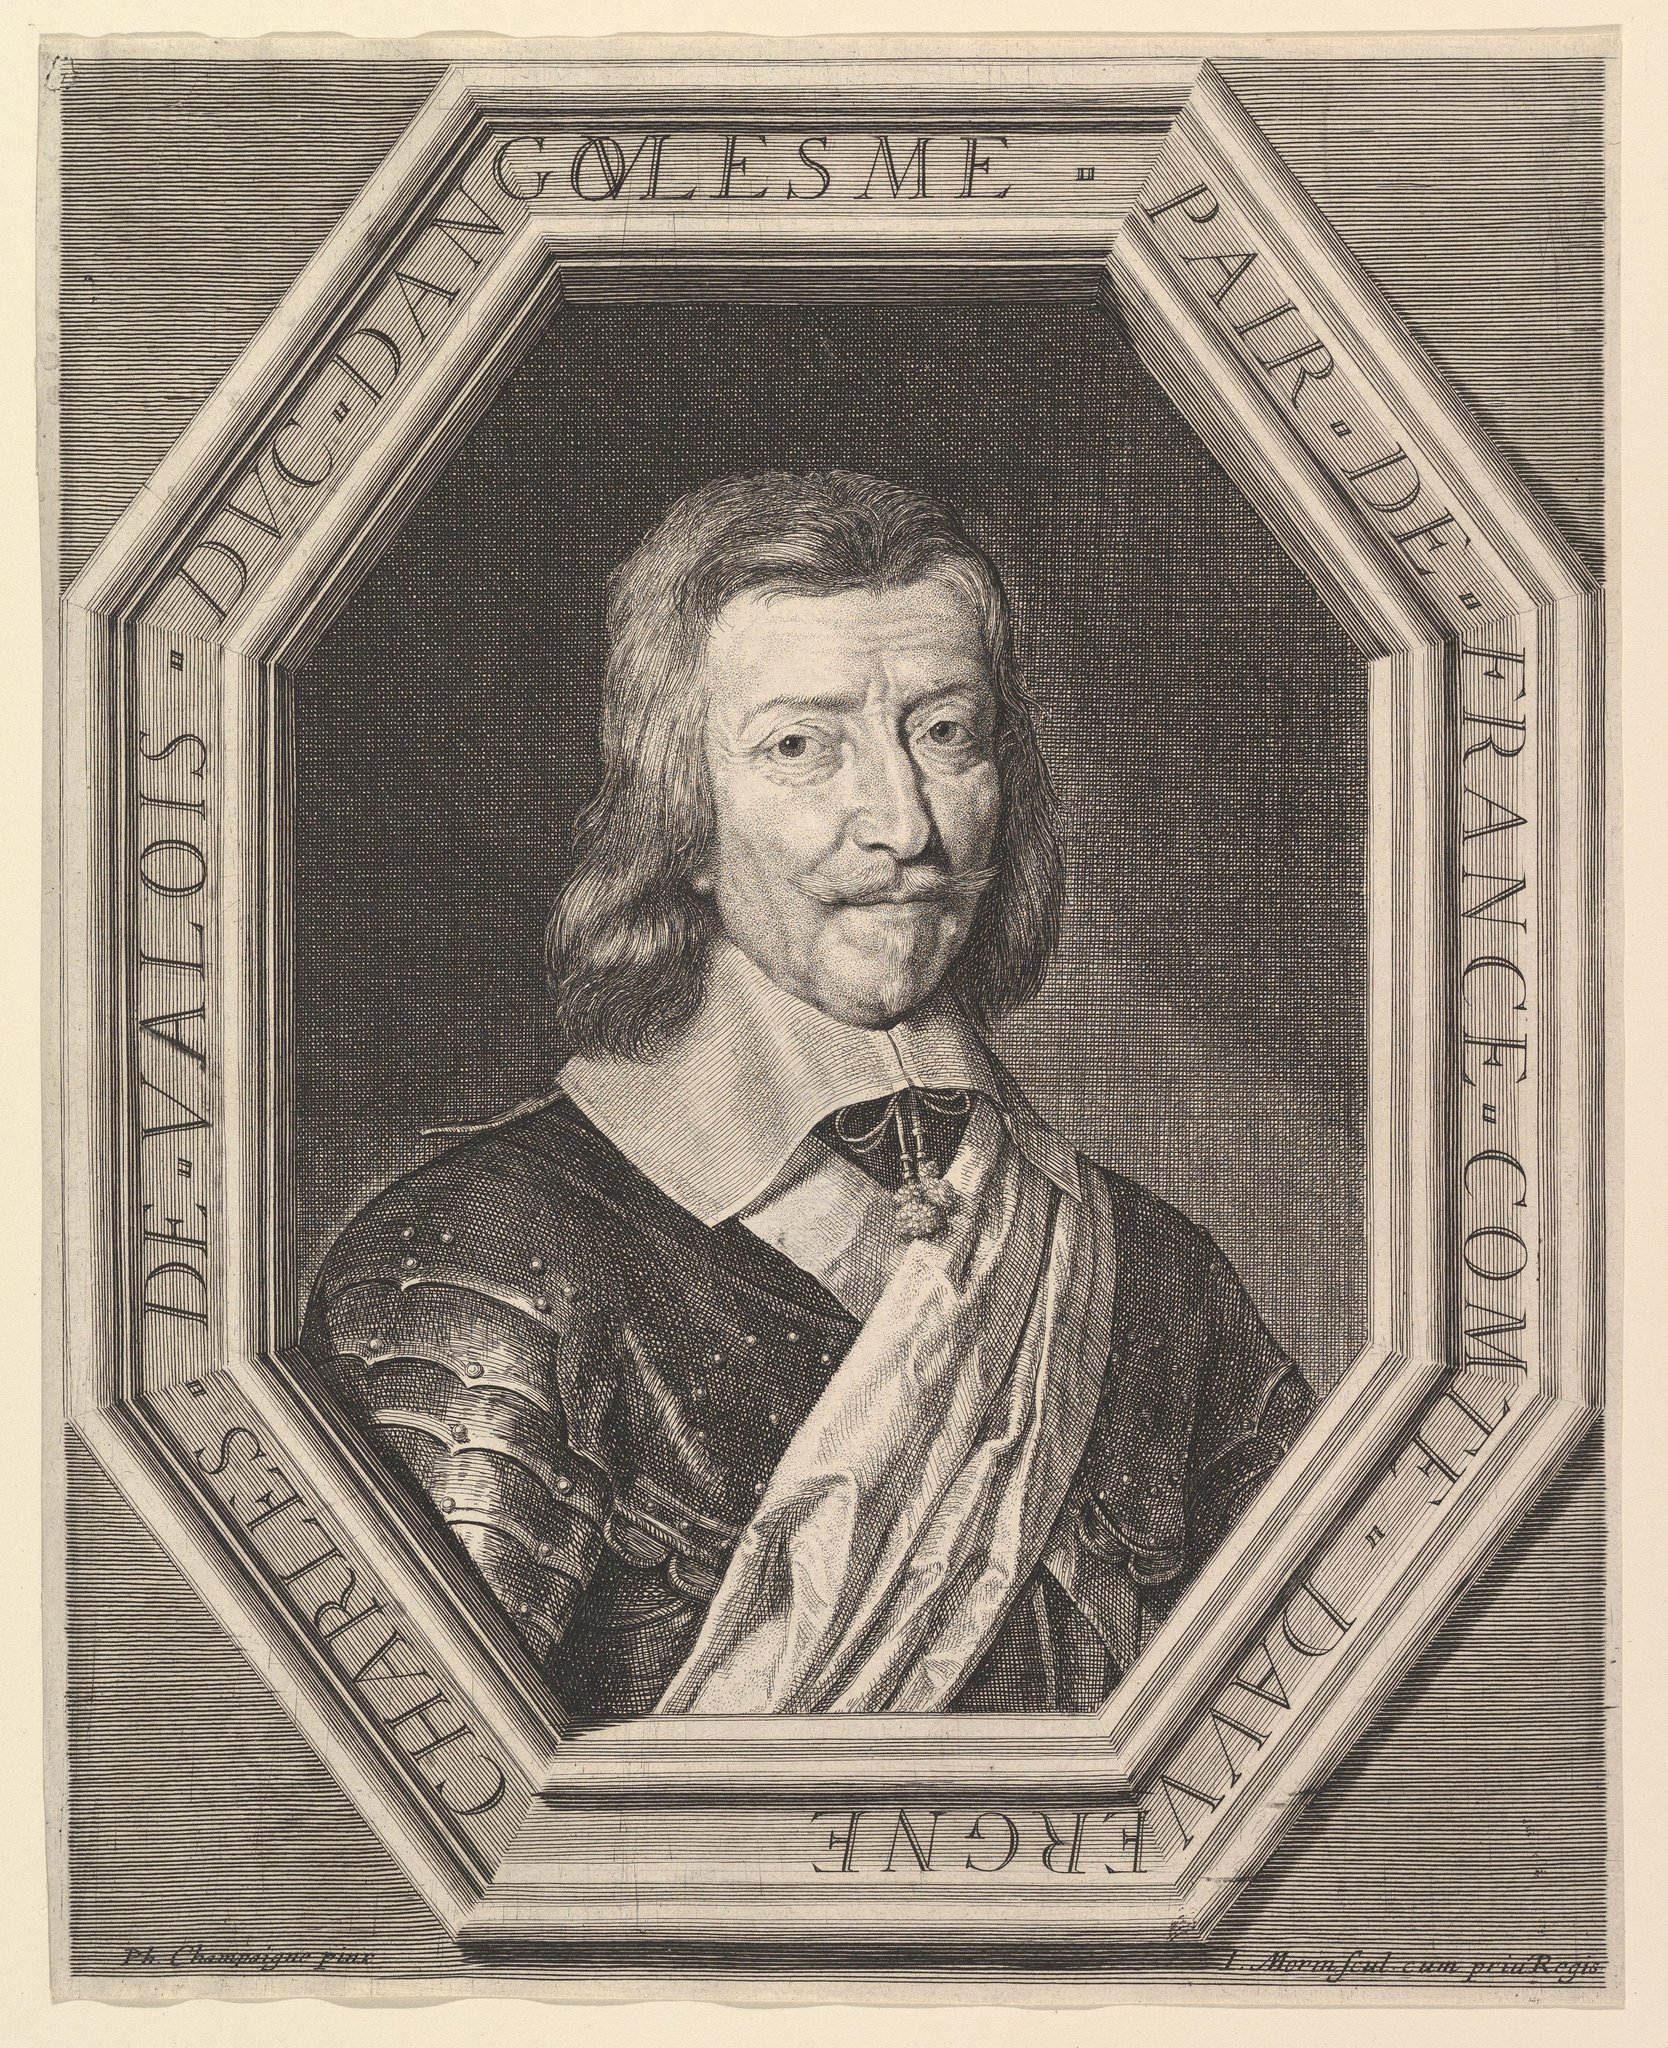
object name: print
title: Charles de Valois, duc d'Angouleme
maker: jean morin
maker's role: artist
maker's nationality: french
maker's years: 1605-1650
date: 1605-1650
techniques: etching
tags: men,portraits